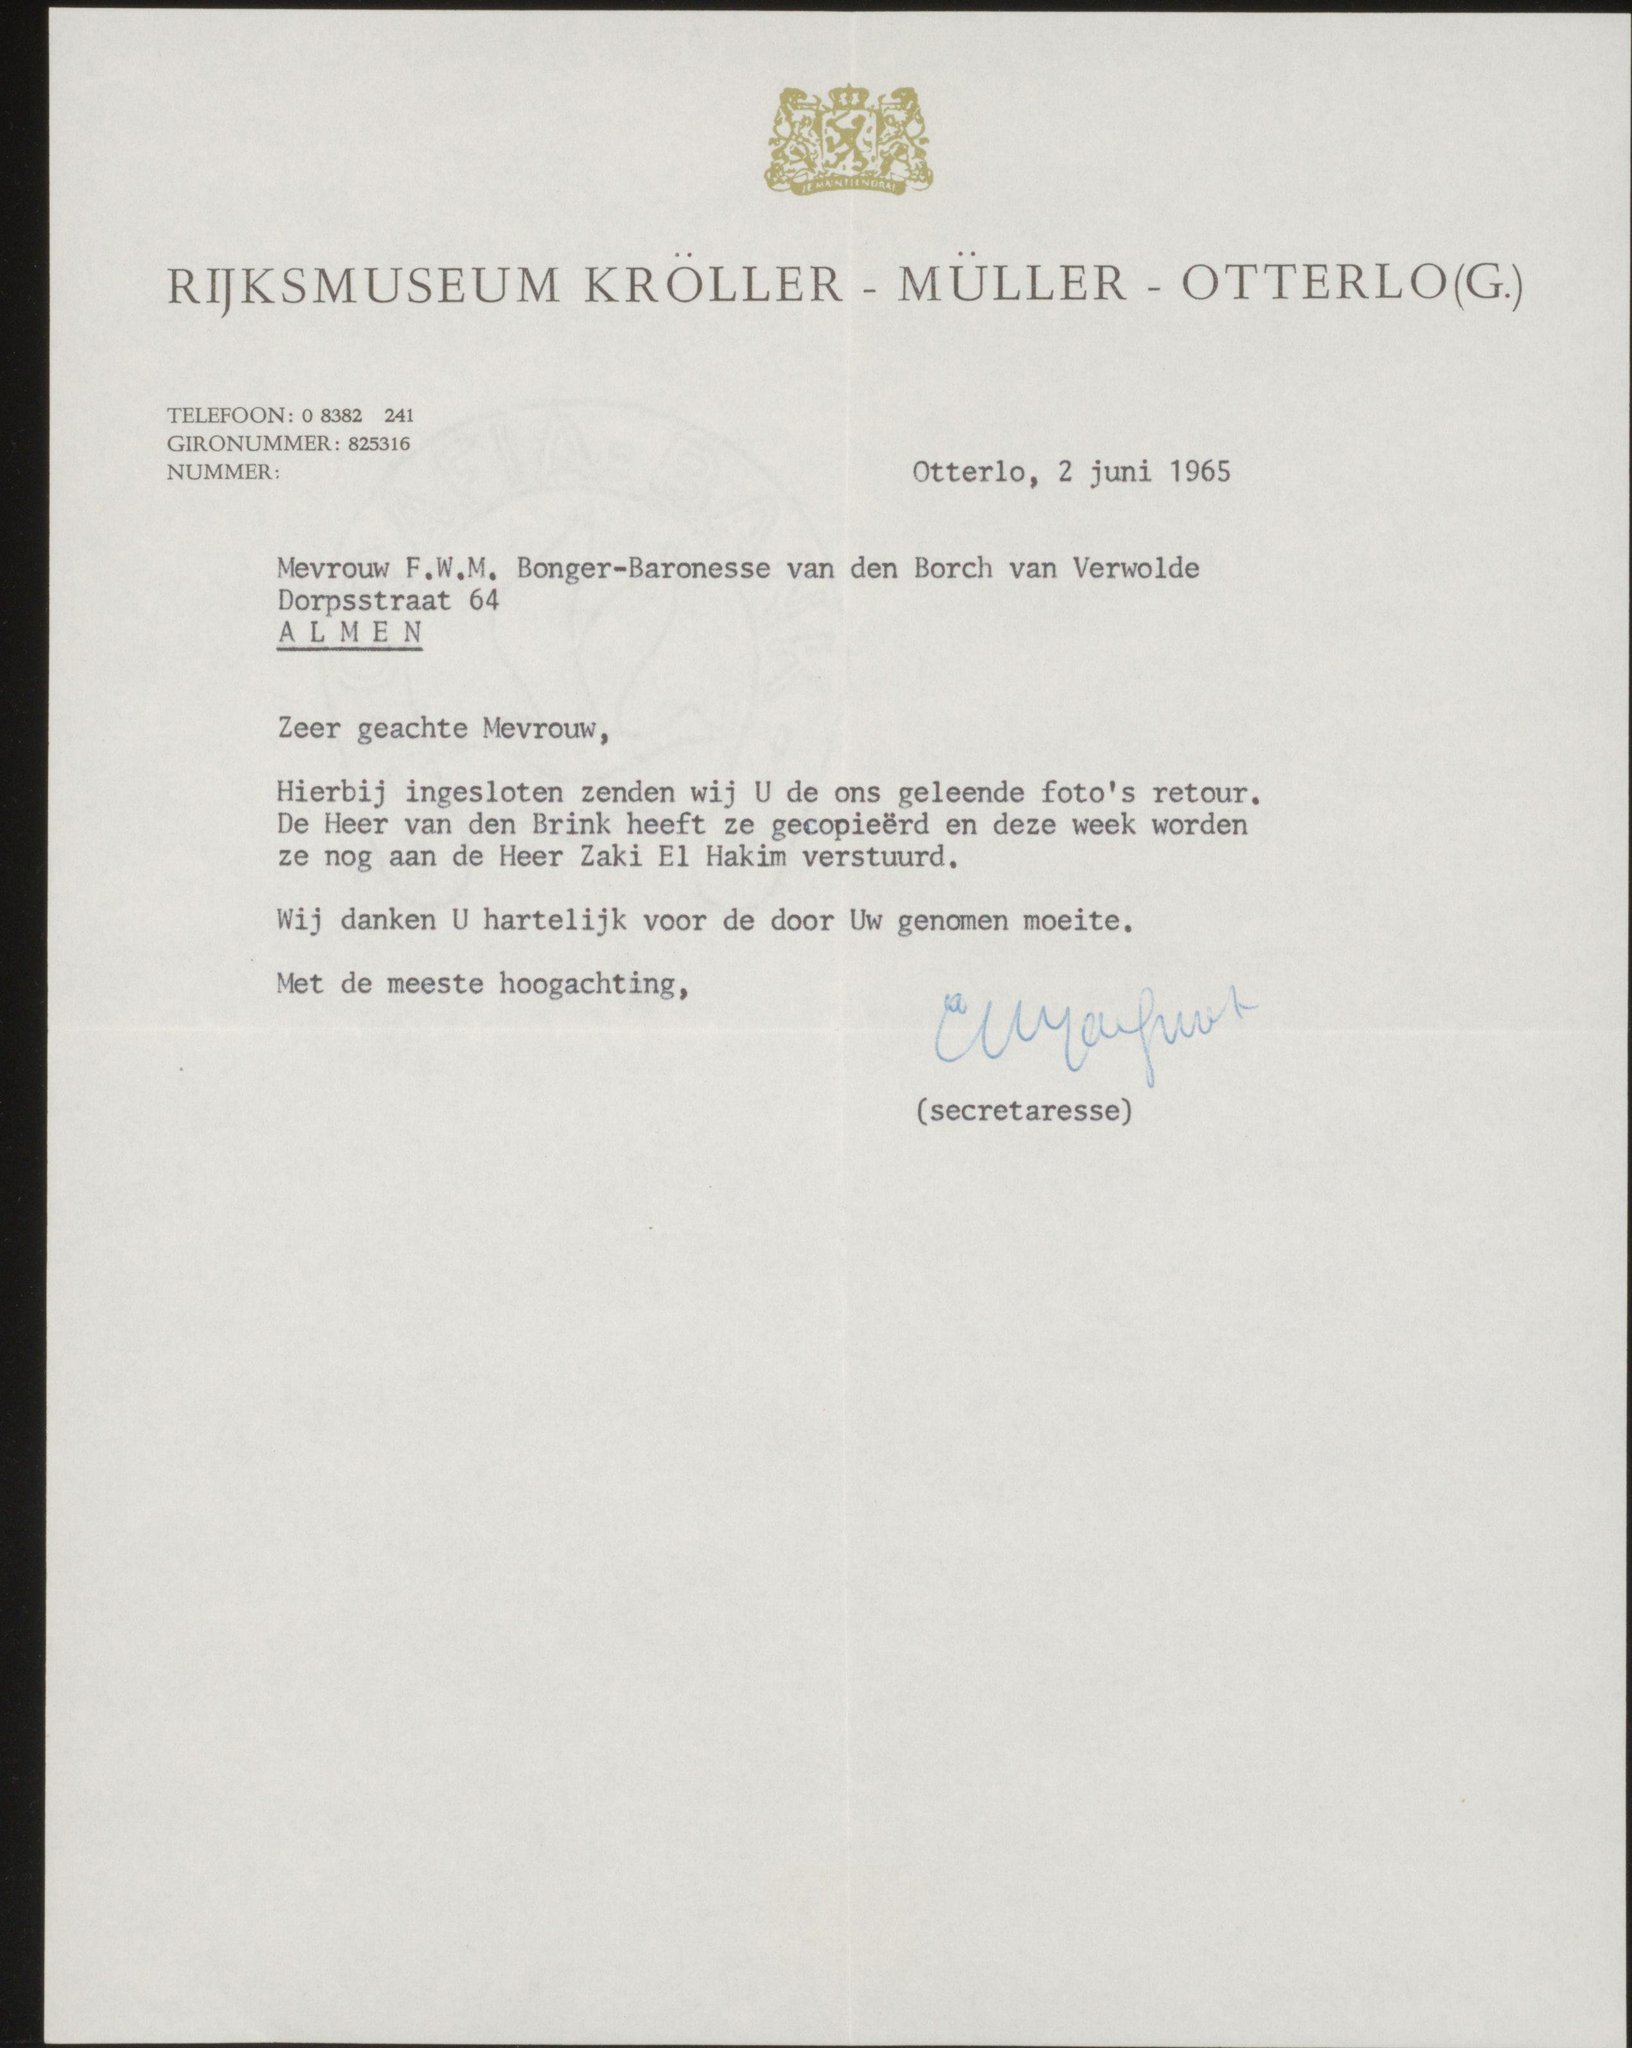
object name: letter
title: Brief aan Françoise W.M. Bonger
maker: Anonymous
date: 1965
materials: ink, paper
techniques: pen, typewriting, writing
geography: otterlo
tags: zaki el-hakim, françoise w.m. bonger, photography, cinematography